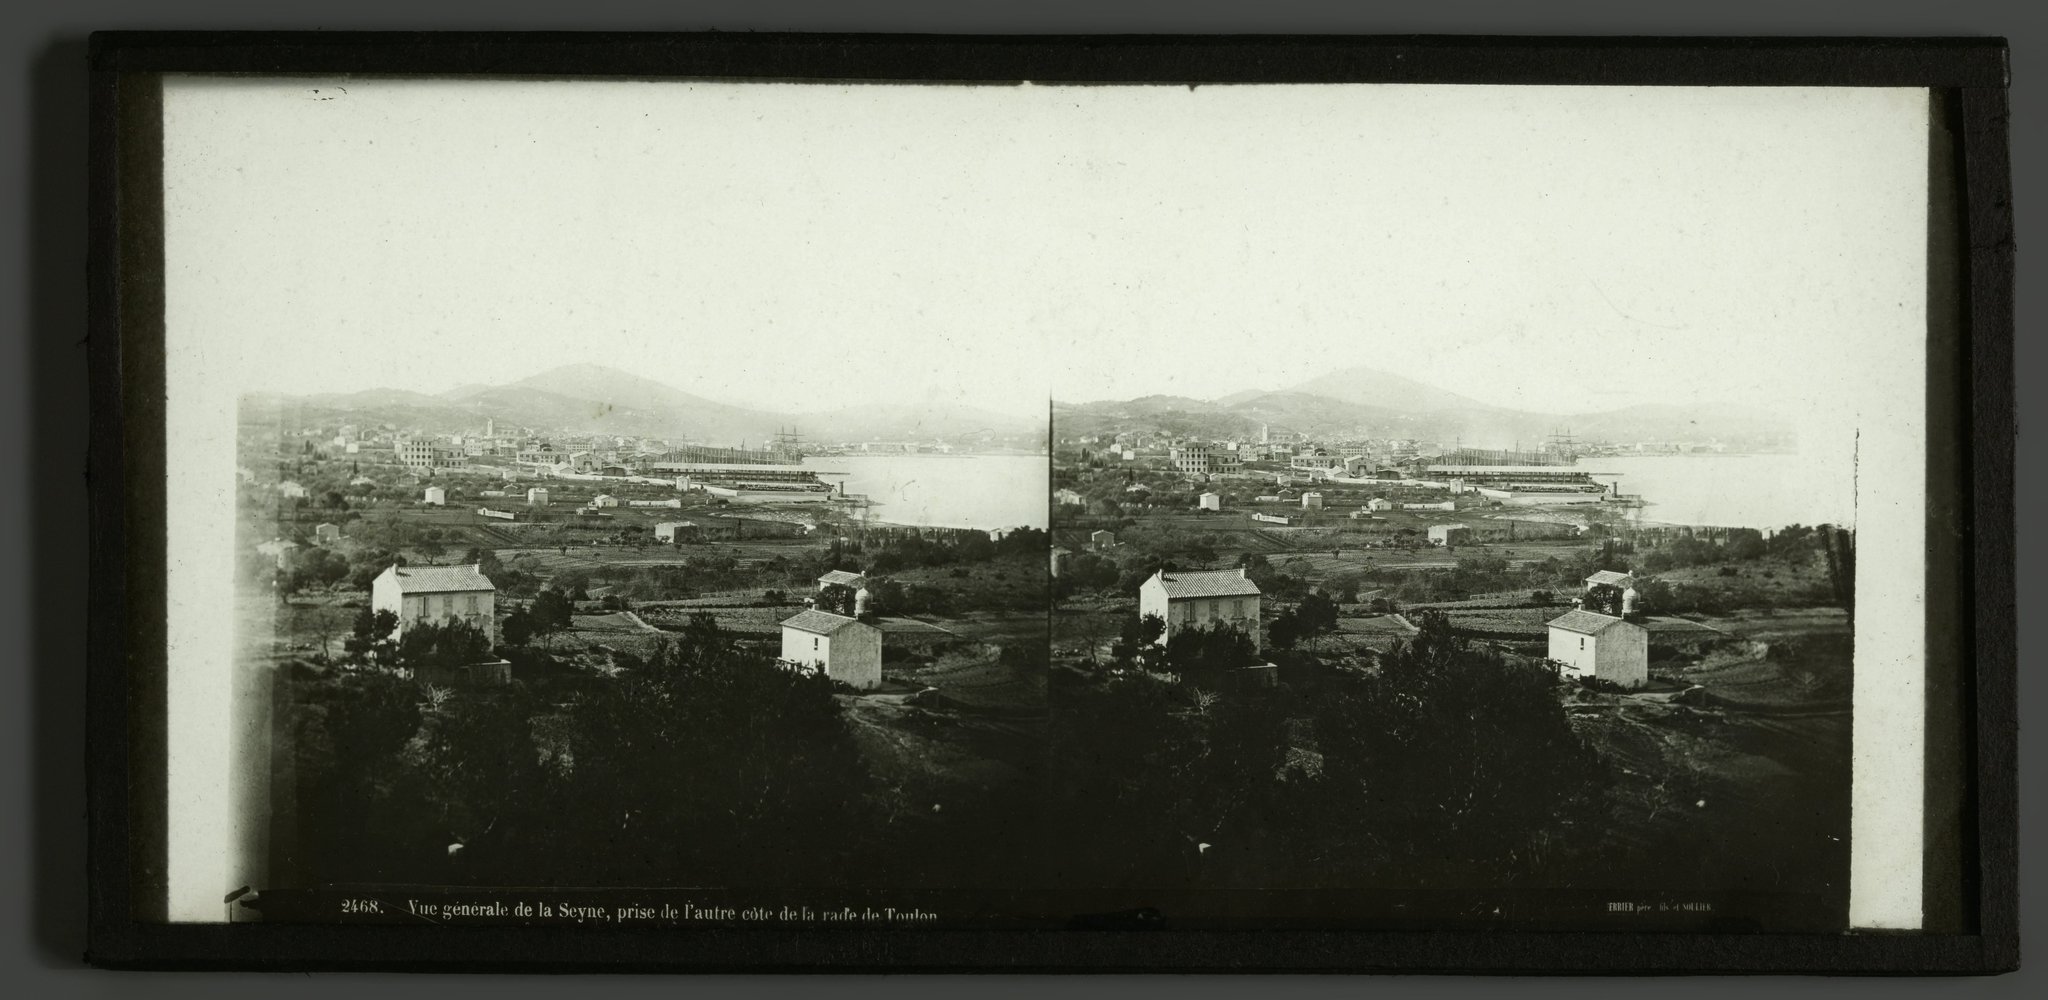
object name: stereoscopic photograph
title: Vue générale de la Seyne, prise de l'autre côté de la rade de Toulon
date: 1860-1870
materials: glass, paper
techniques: slide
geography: toulon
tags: prospect of city, town panorama, silhouette of city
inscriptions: number: ‘2468’